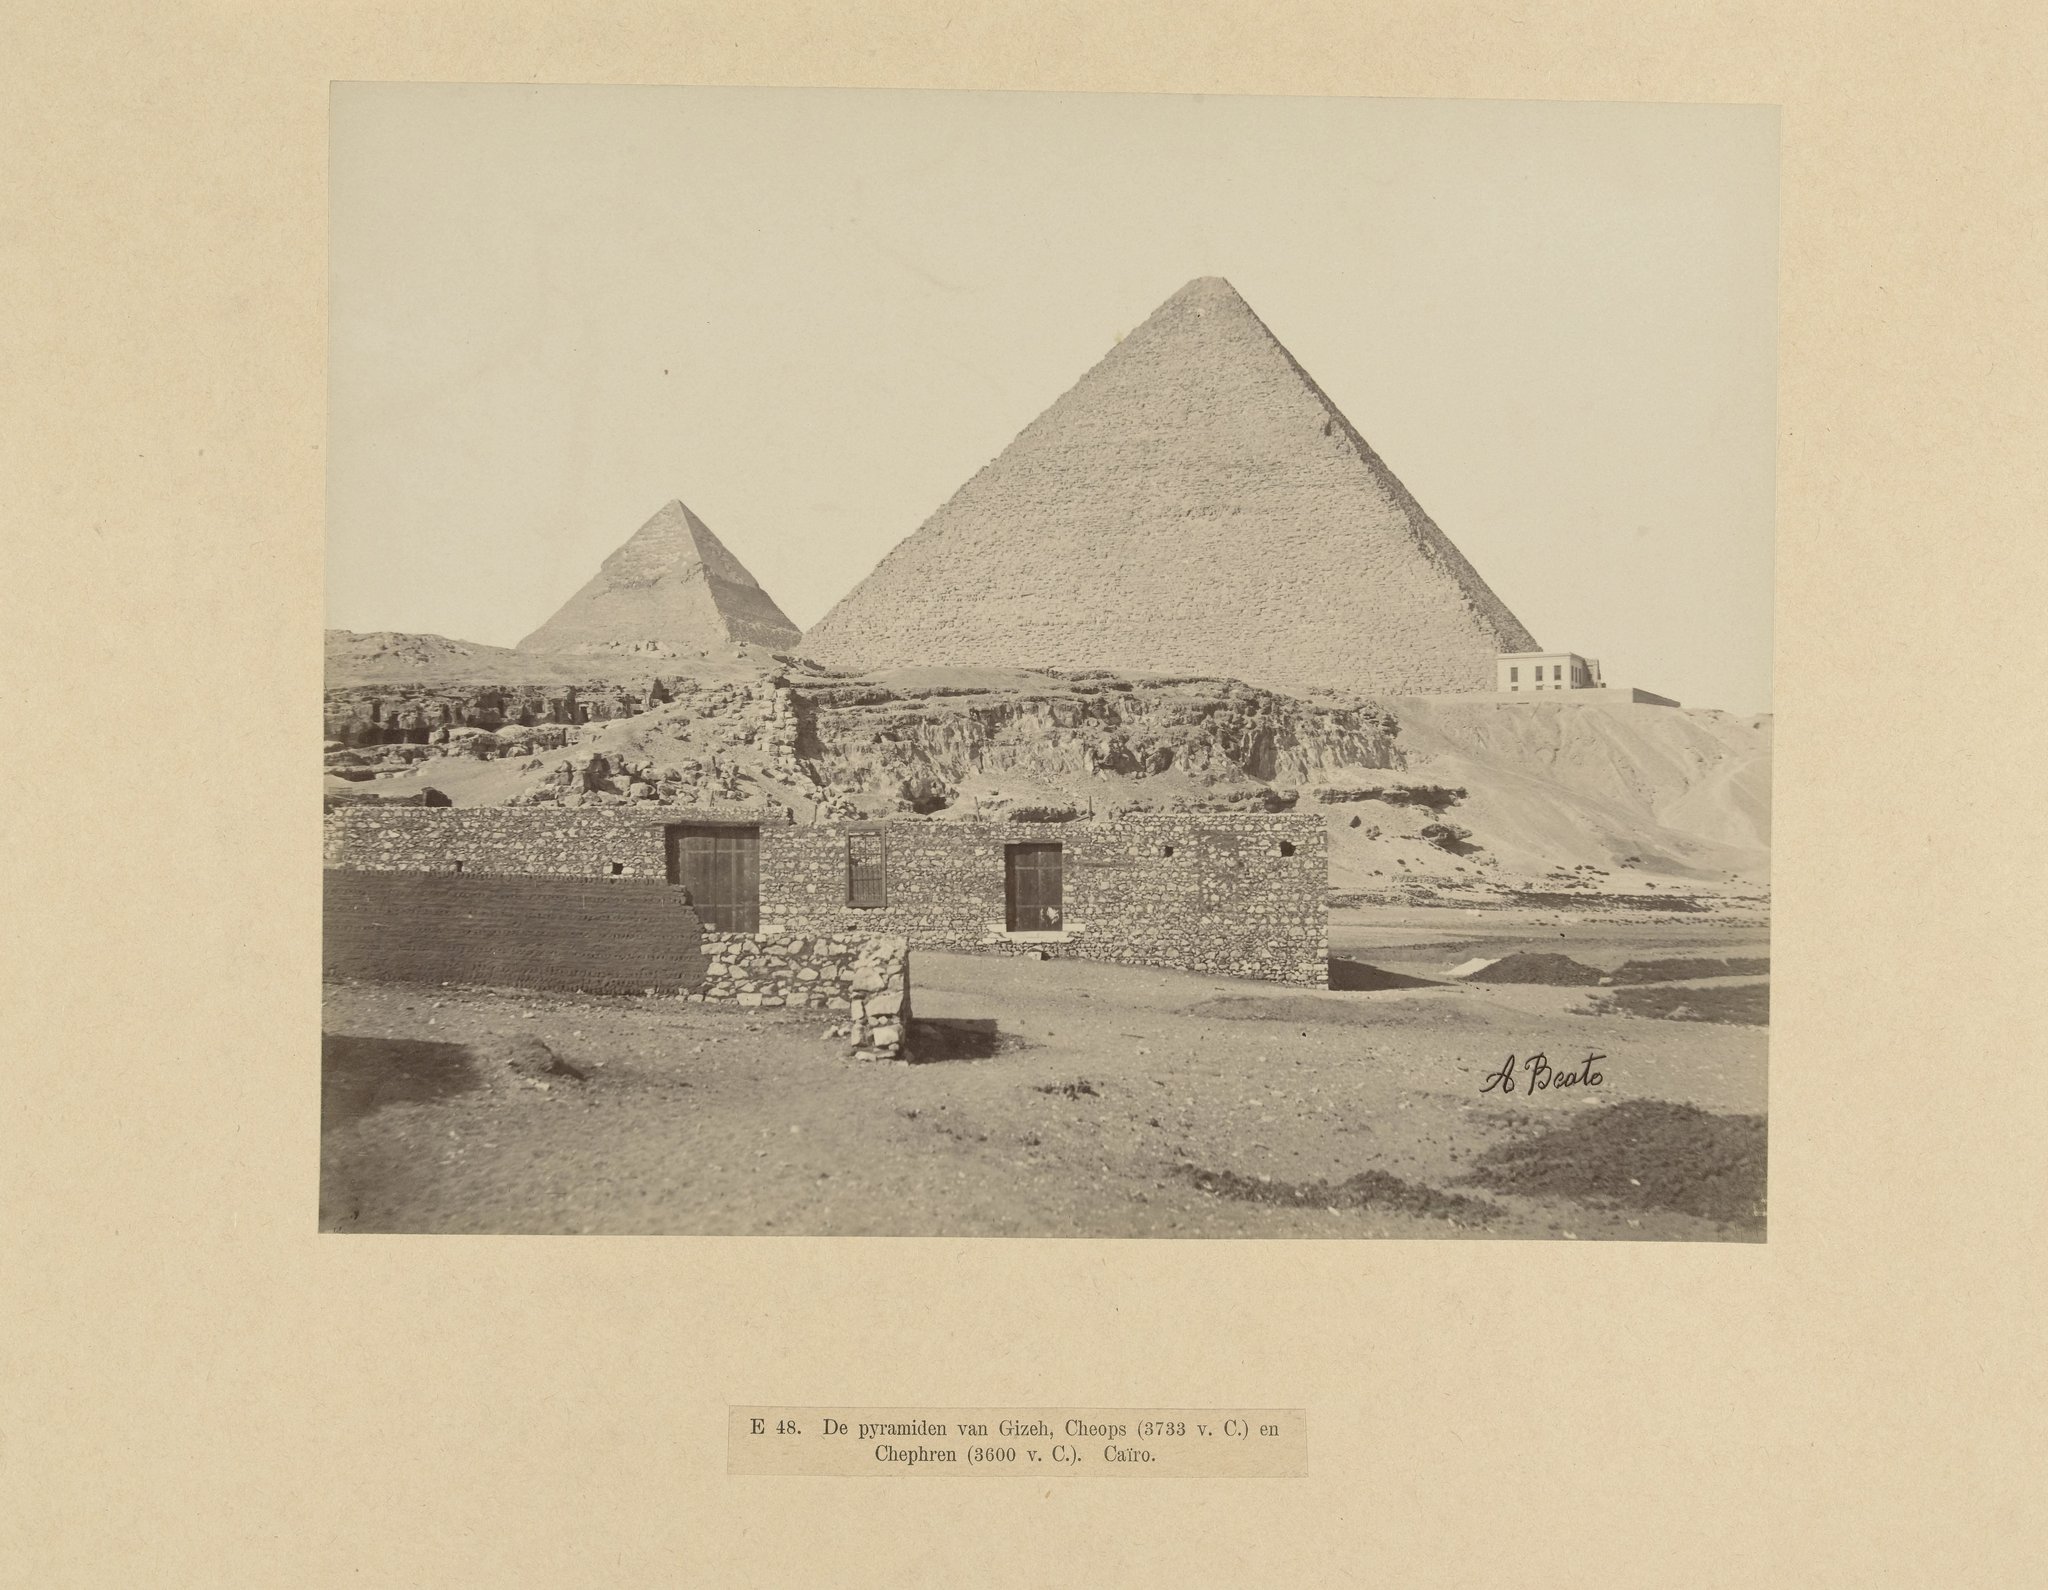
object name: photograph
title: Piramides van Cheops en Chefren, Gizeh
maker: antonio beato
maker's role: fotograaf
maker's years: 1835-1906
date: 1862-1895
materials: cardboard, paper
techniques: albumen print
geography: gizeh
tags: egyptian pyramids (wonder of the world)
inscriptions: stamp: ‘Gemeentelijke bibliotheek/ Rotterdam’, check stamp: ‘Bristol/ L.M.’, title: ‘E 48. De pyramiden van Gizeh, Cheops (3733 v. C.) en/ Chephren (3600 v. C.). Caïro.’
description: Onderdeel van een groep door fotograaf Richard Polak op reis verzamelde foto’s. Deze foto is samen met andere op zijn reizen verzamelde foto's tentoongesteld bij de Rotterdamsche Kunstkring (1895), Arti en Amicitiae te Amsterdam (1897-1898?) en Societeit 't Collegie te Kampen (datum vooralsnog onbekend).